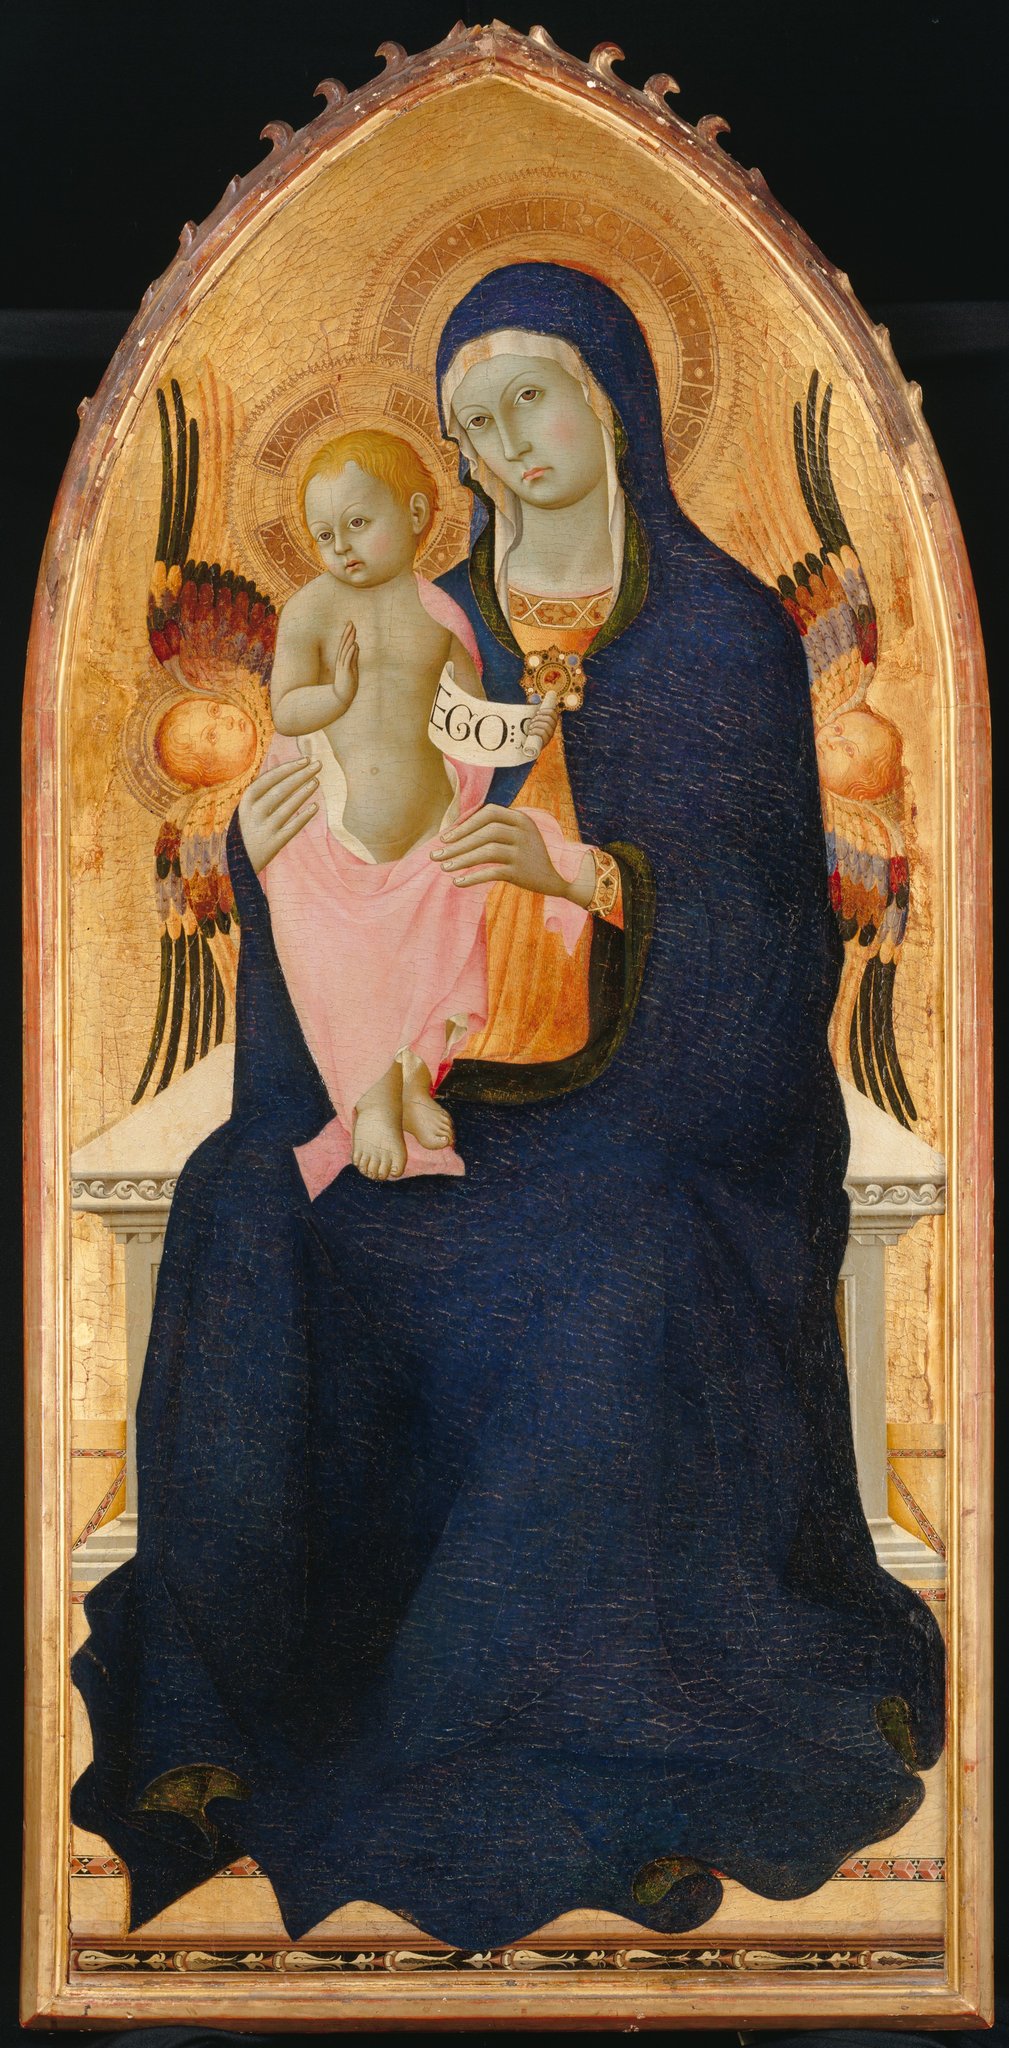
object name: painting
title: Madonna and Child Enthroned with Two Cherubim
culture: italian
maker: osservanza master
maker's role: artist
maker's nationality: italian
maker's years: 1425-1450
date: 1435-1440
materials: gold leaf, paint, wood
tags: angels,madonna and child